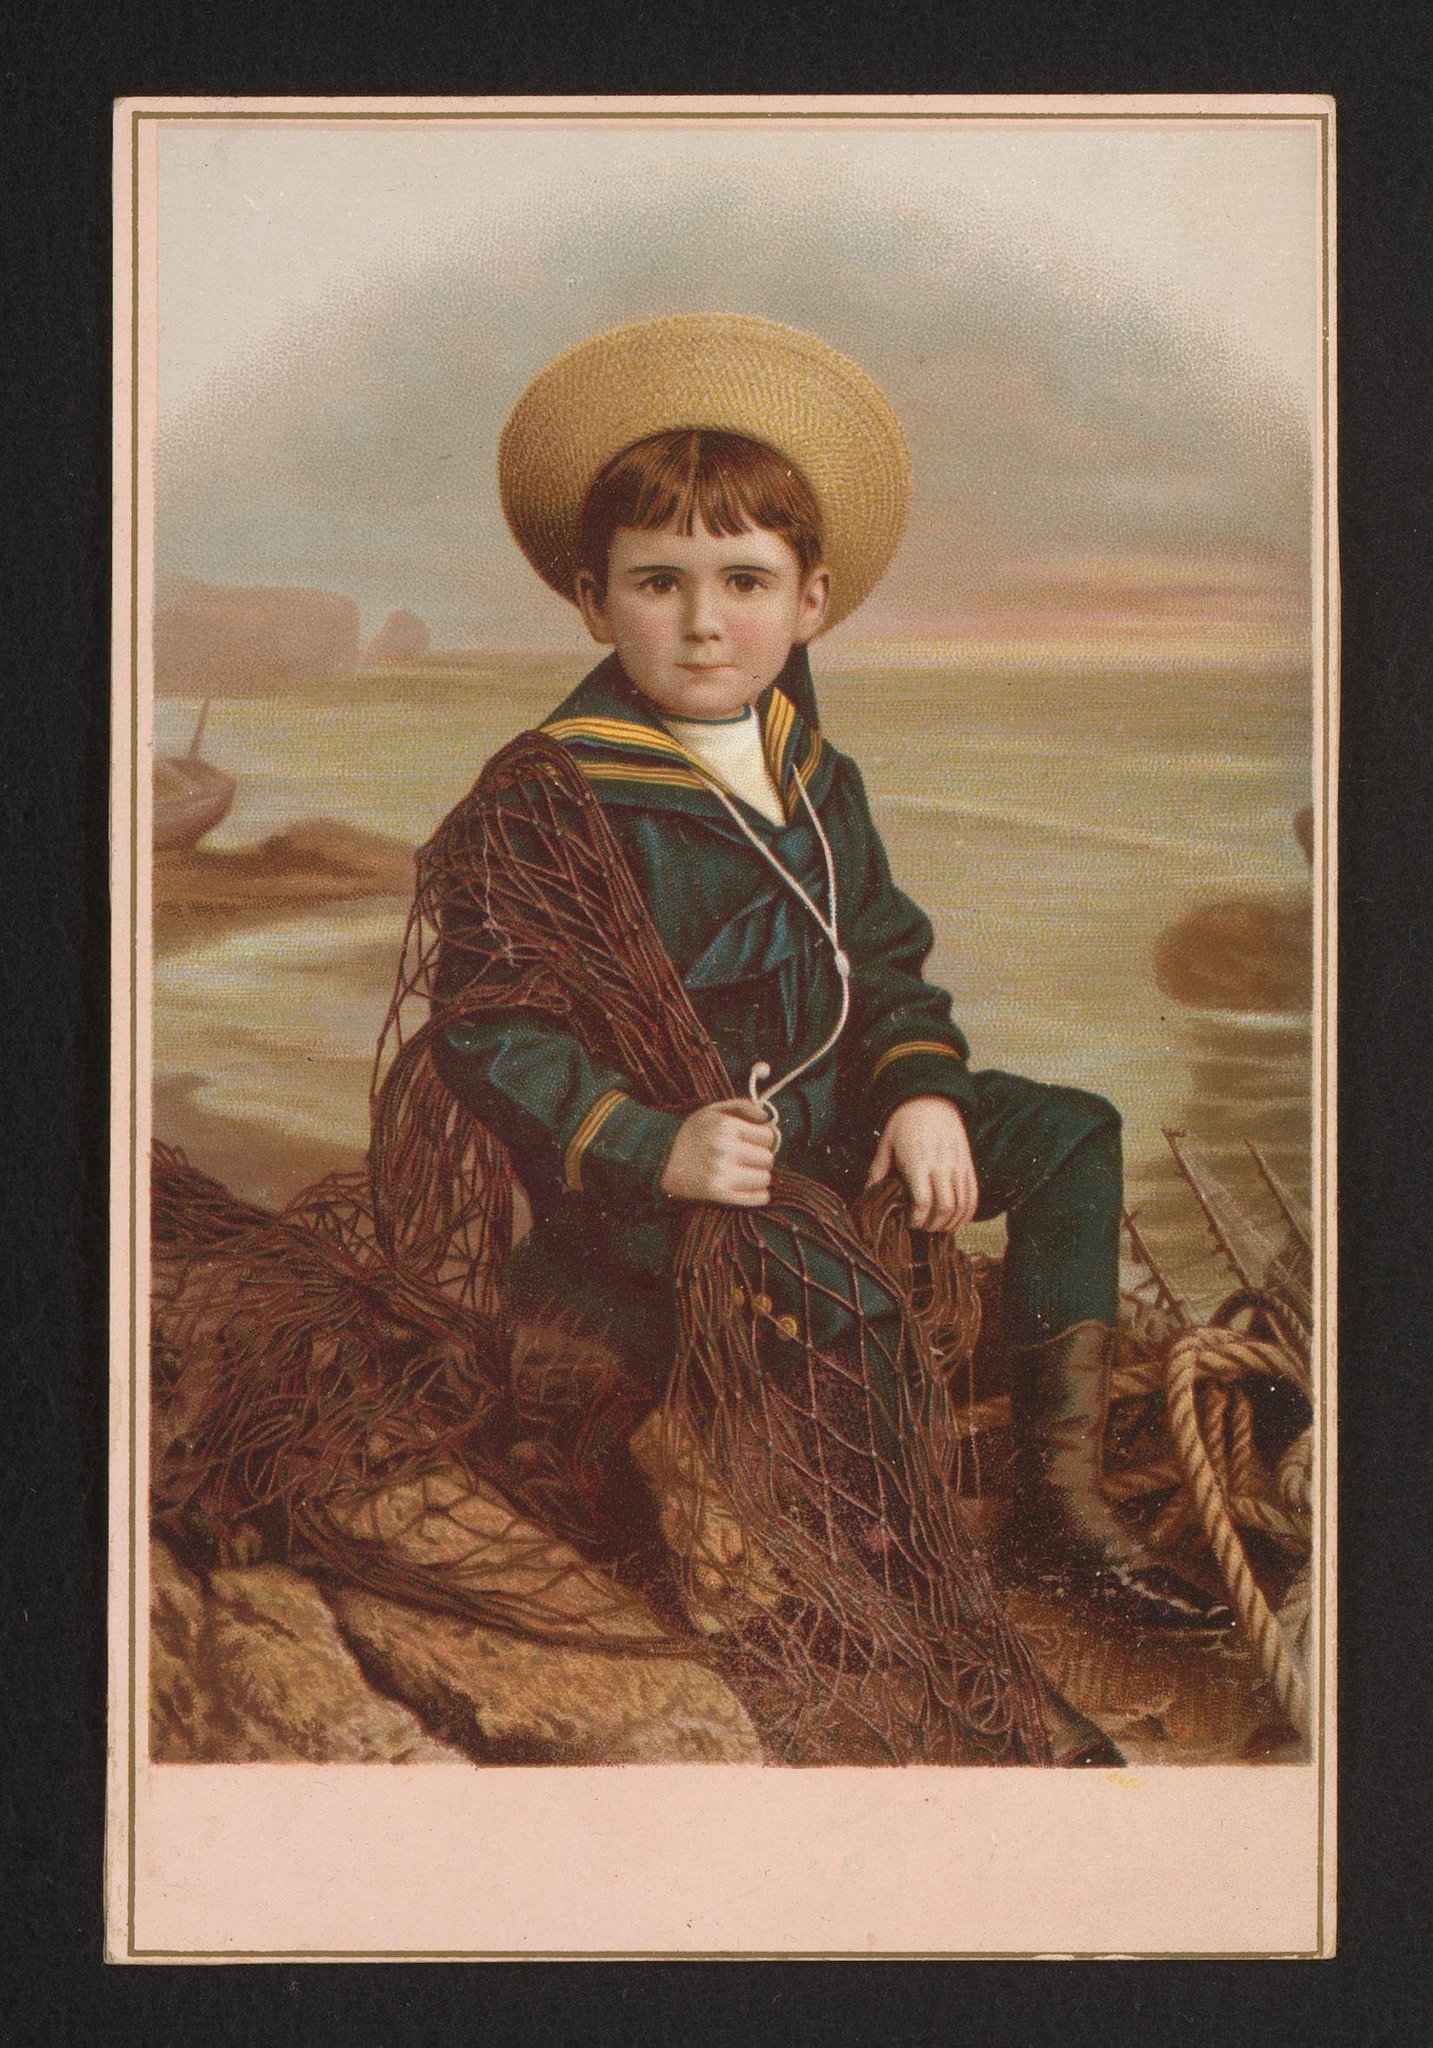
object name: print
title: Portret van een zittende jongen met hoed en visnet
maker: Anonymous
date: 1880-1920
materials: cardboard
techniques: chromolithography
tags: sitting figure, boy (child between toddler and youth), historical persons, fisherman